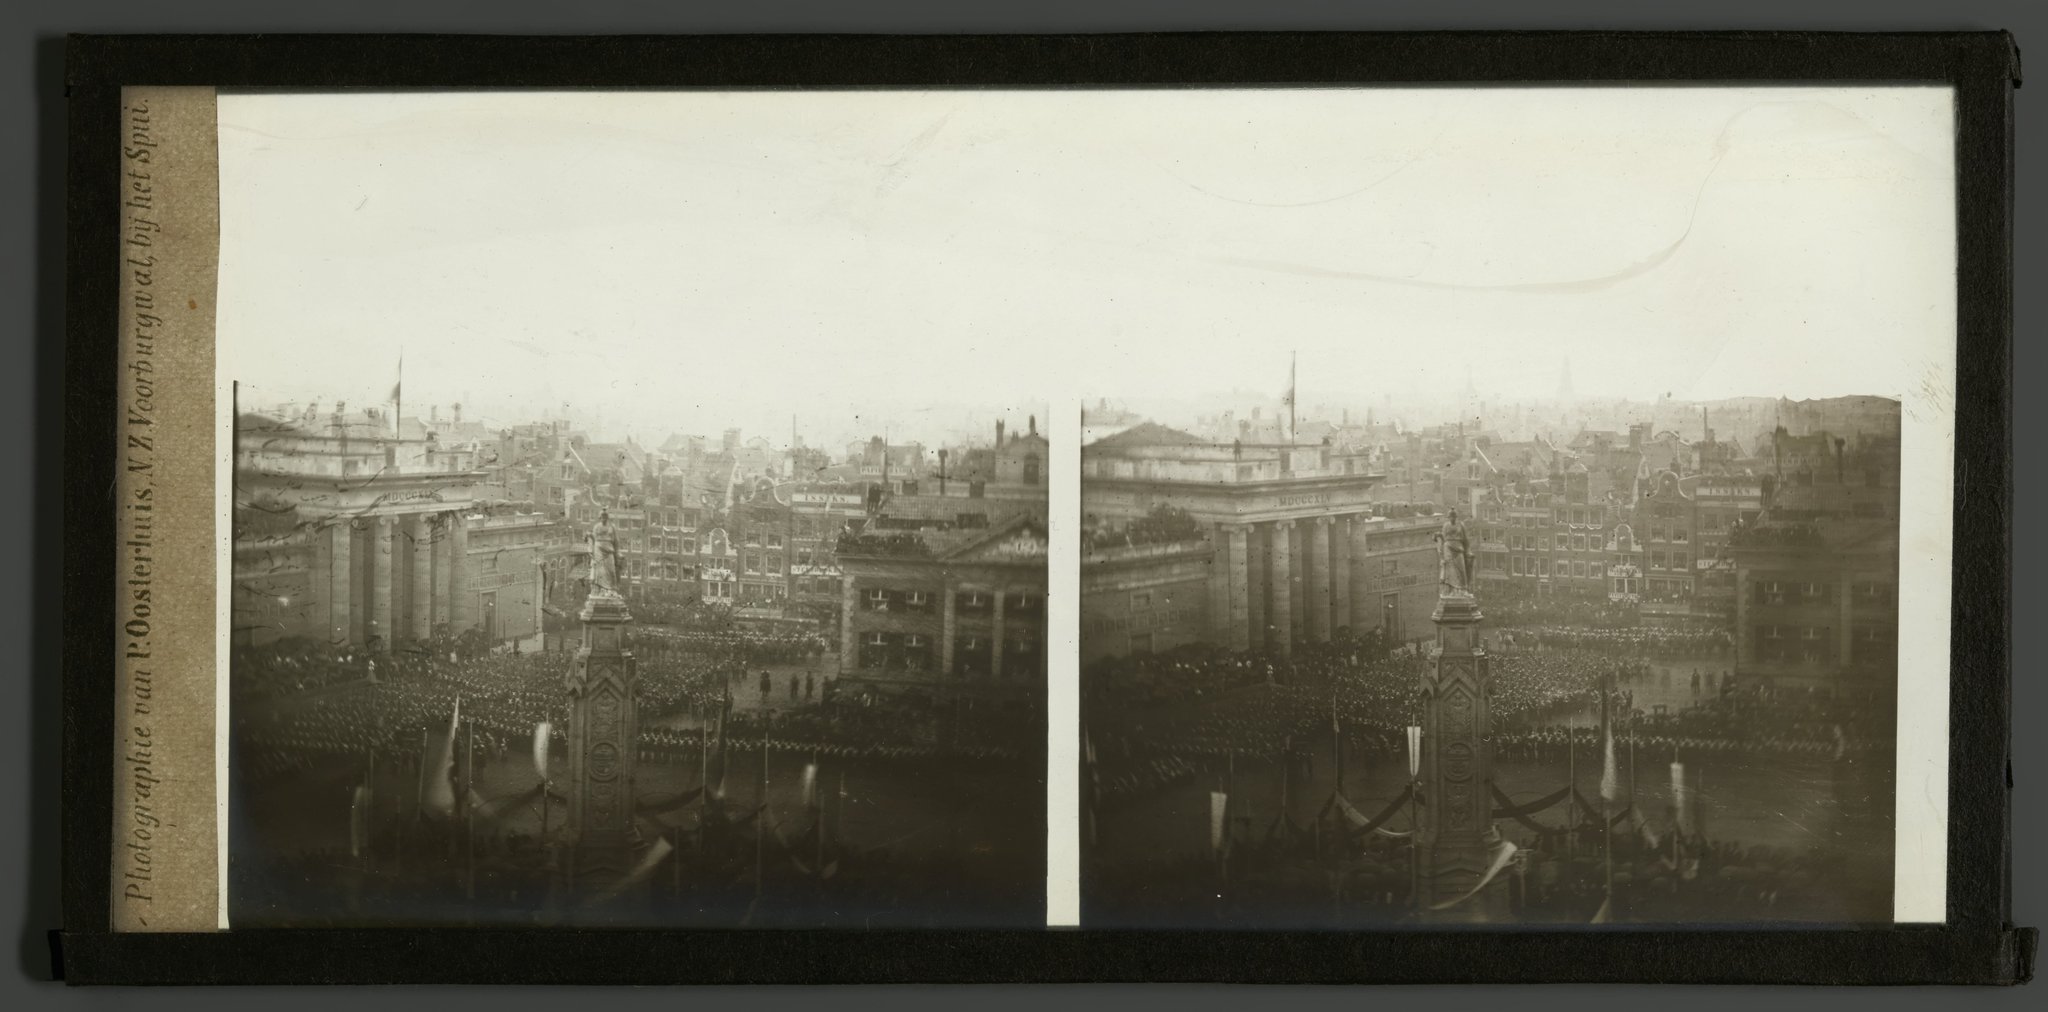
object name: stereoscopic photograph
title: Onthulling van `Naatje op de Dam' (het Monument ter herinnering aan de Volksgeest van 1830-1831) in Amsterdam op 27 augustus 1856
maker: pieter oosterhuis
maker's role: draughtsman, print maker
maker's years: 1816-1885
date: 1856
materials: glass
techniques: slide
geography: amsterdam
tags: public festivities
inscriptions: address: ‘N.Z. Voorburgwal, bij het Spui.’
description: Het Damplein tijdens de onthulling van het Monument ter Herinnering aan den Volksgeest van 1830 en 1831 op 27 augustus 1856. Oosterhuis maakte de opname vanuit de bovenste verdieping van het Koninklijk Paleis op het moment dat de verzamelde Amsterdamse wezen het volkslied 'Wien Neêrlands bloed' zongen, om ongeveer half twaalf.